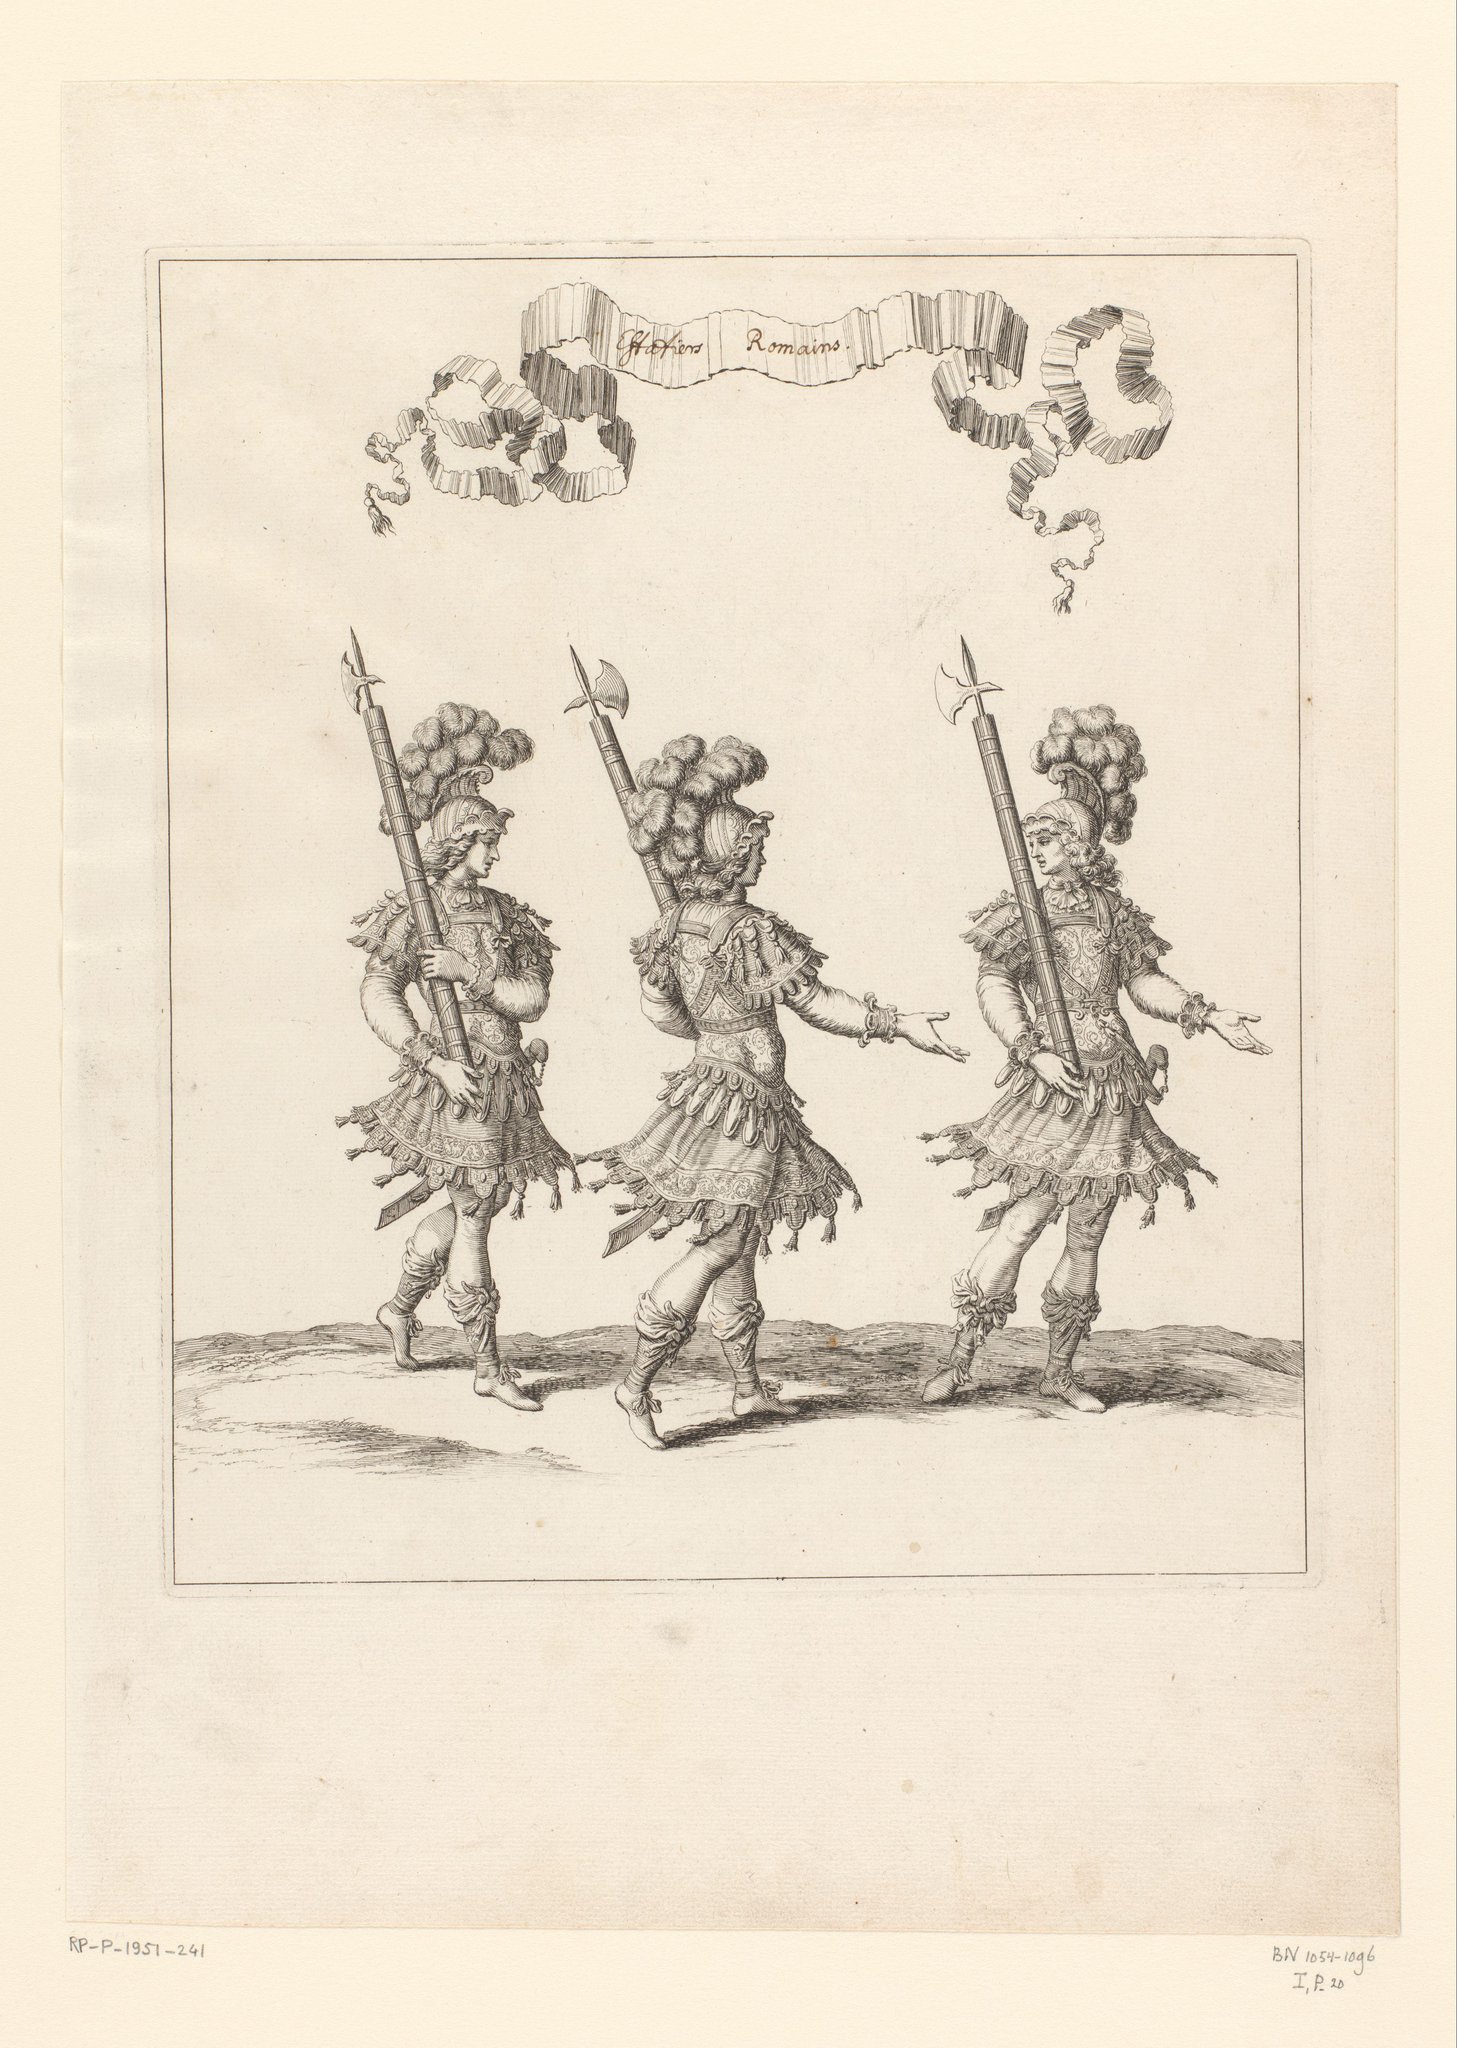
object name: book illustration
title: Drie voetknechten met fasces in Romeins kostuum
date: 1670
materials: paper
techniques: etching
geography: paris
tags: tournament, festivities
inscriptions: inscription, collector's mark: Lugt 2228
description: Prent uit: Perrault, Charles. Courses de testes et de bague faites par le Roy et par les princes et seigneurs de sa cour en l'année M.DC.LXII. Parijs: Imprimerie Royale, 1670. De prenten illustreren de door Lodewijk XIV georganiseerde festiviteiten in juni 1662 te Tuileries, zoals steekspelen met figuren in verschillende kostuums.